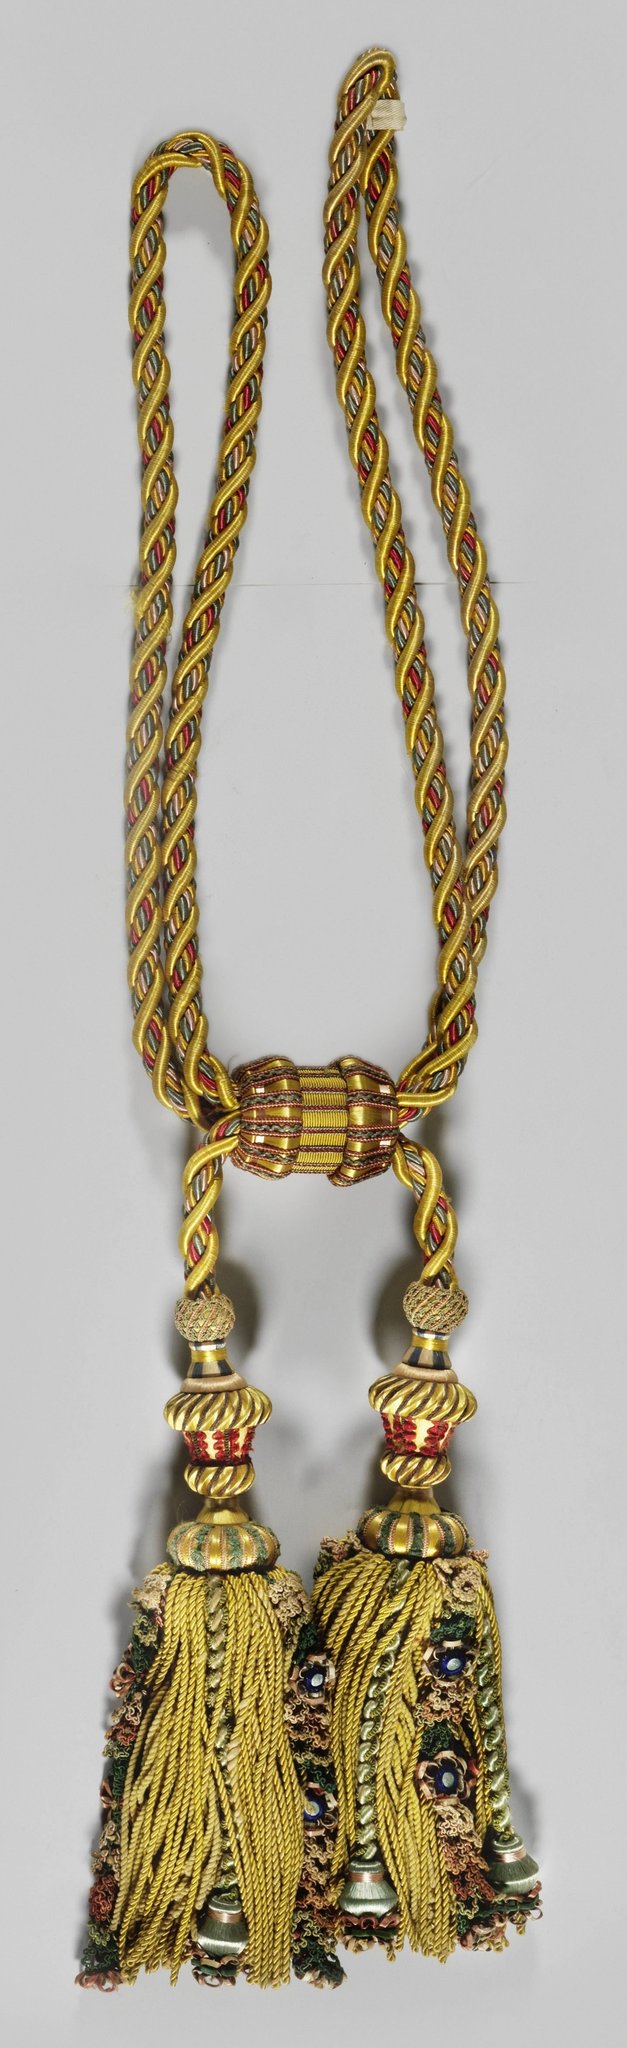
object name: tieback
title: Embrasse behorend bij een stel gordijnen met bloemdessin op geel fond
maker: carel hubertus windt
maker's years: 1804-1860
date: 1850-1860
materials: silk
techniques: lampas, weave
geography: the hague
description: Embrasse behorend bij een stel gordijnen van zijde met bloemdessin op geel fond, afkomstig uit de kleine danszaal van Paleis Noordeinde.